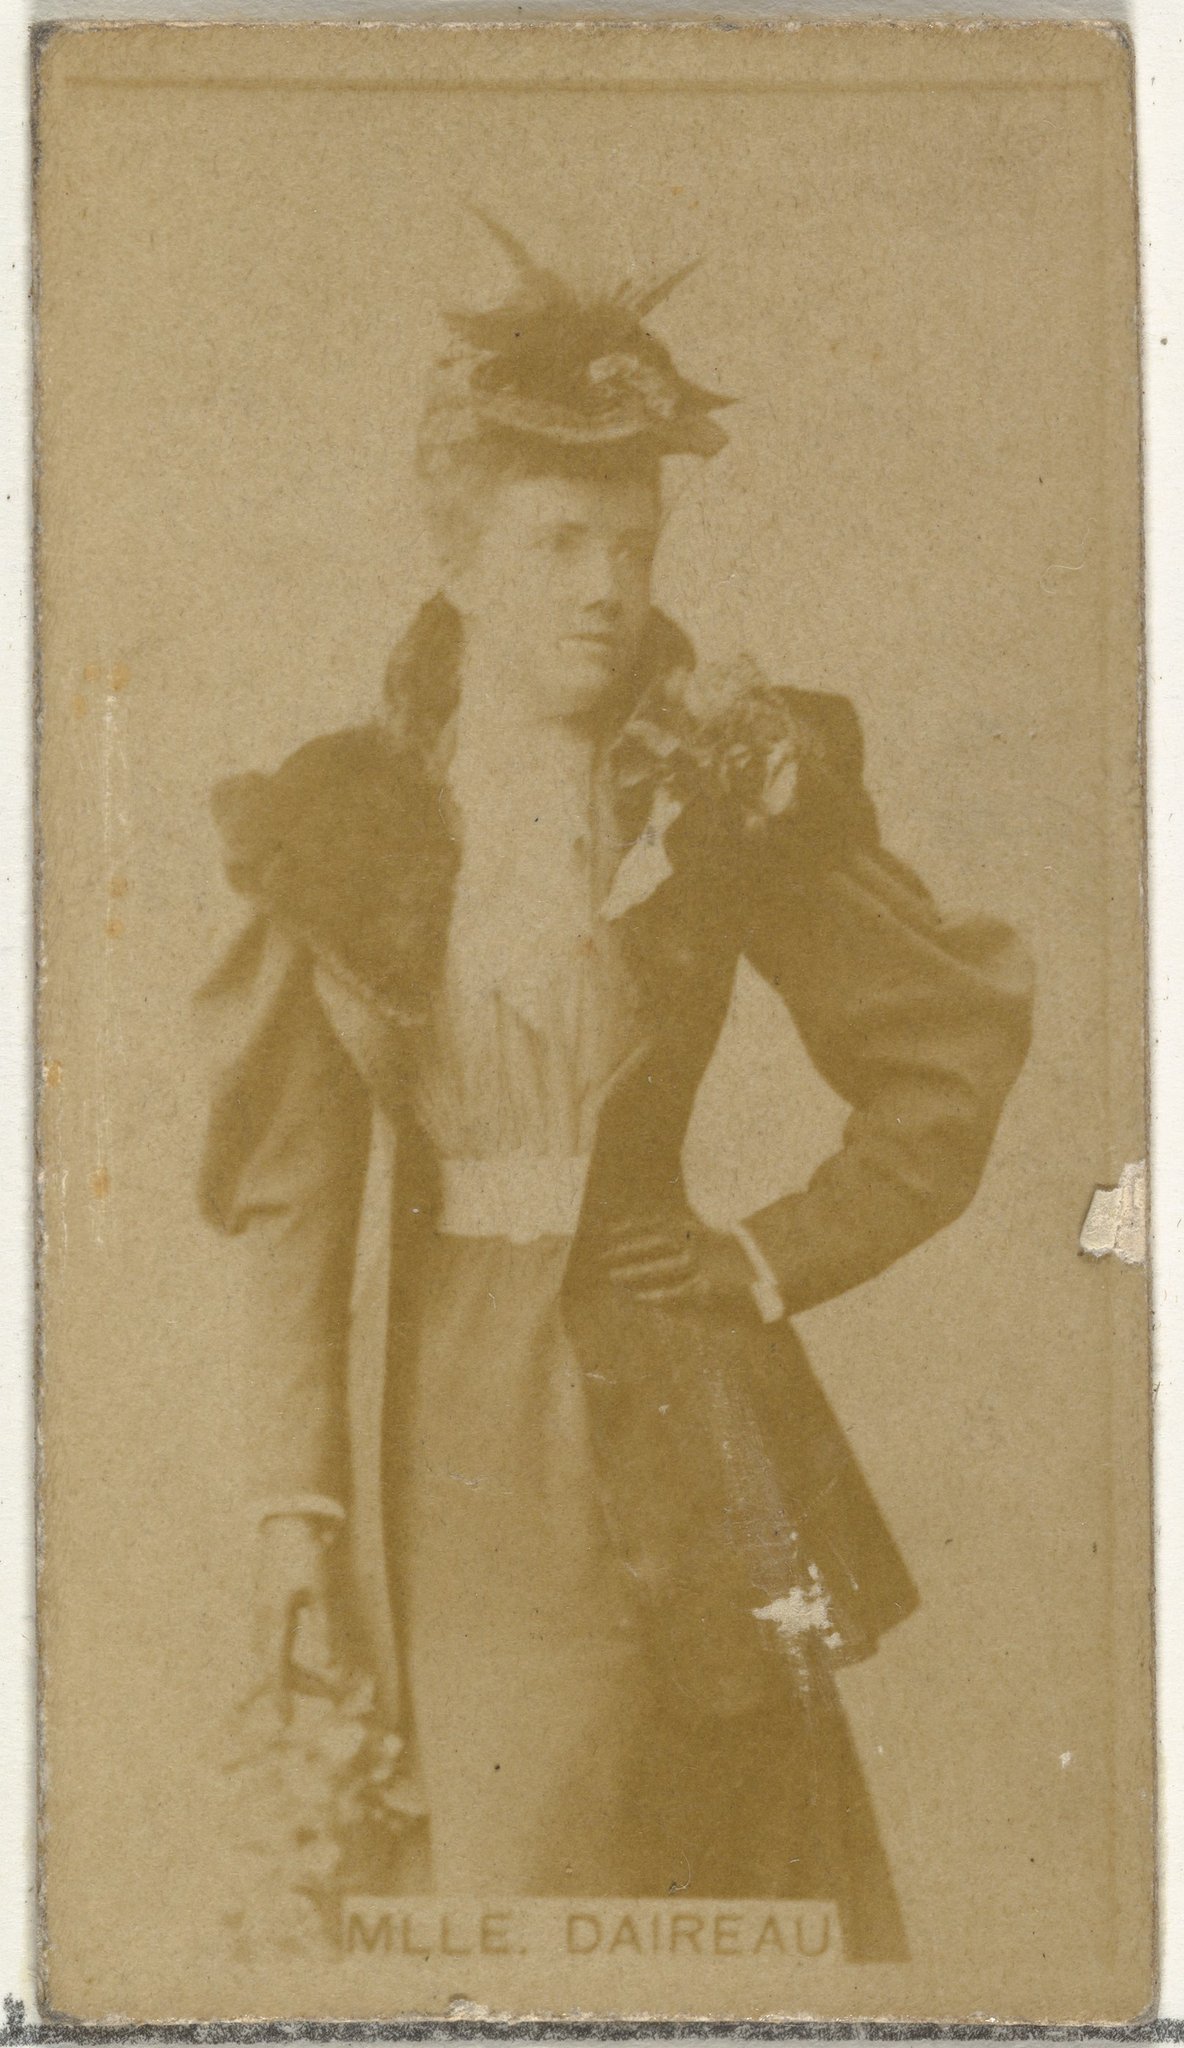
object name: photograph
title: Mlle. Daireaux, from the Actors and Actresses series (N145-8) issued by Duke Sons & Co. to promote Duke Cigarettes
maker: w. duke, sons & co.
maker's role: publisher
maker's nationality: american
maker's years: 1870-1920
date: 1891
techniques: albumen silver print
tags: portraits,women,actresses